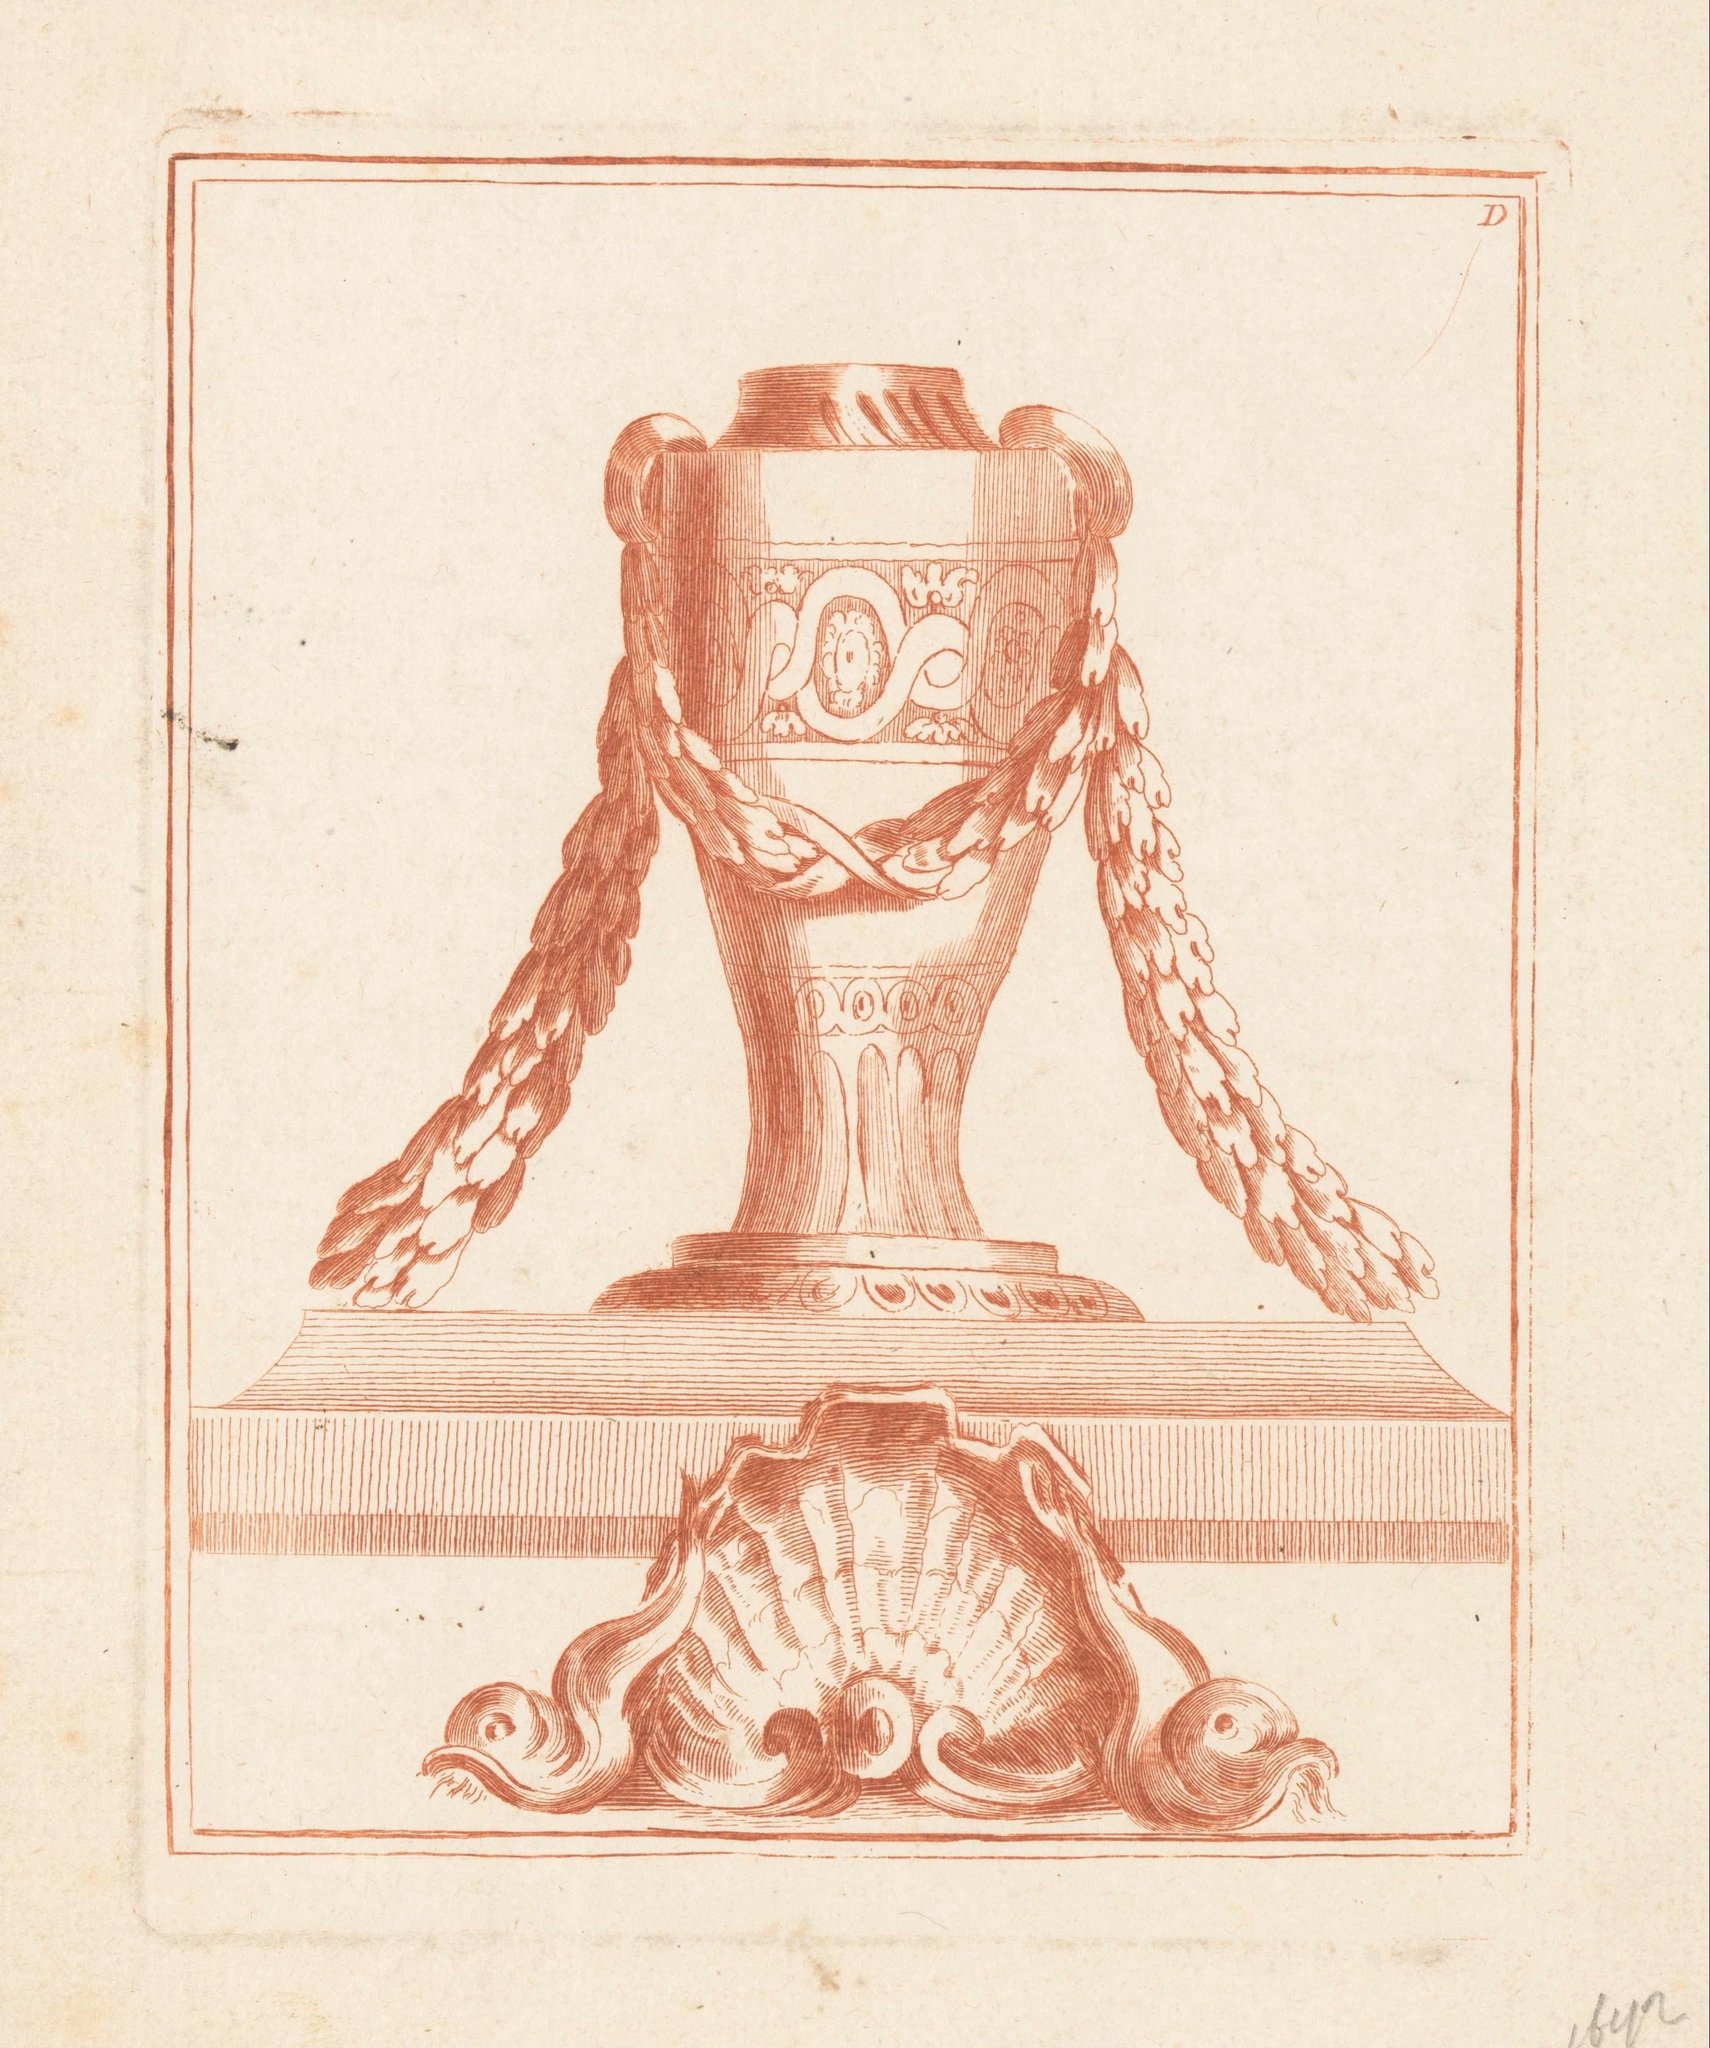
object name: print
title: Vaas met guirlandes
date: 1770-1780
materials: paper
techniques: etching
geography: paris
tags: vase ~ ornament, ornament ~ festoon, garland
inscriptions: collector's mark: Lugt 2228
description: Neoklassieke vaas in de vorm van een urn, gedecoreerd met een guirlande. Onder het blad een schelp met twee dolfijnen. Rechts boven D genummerd.